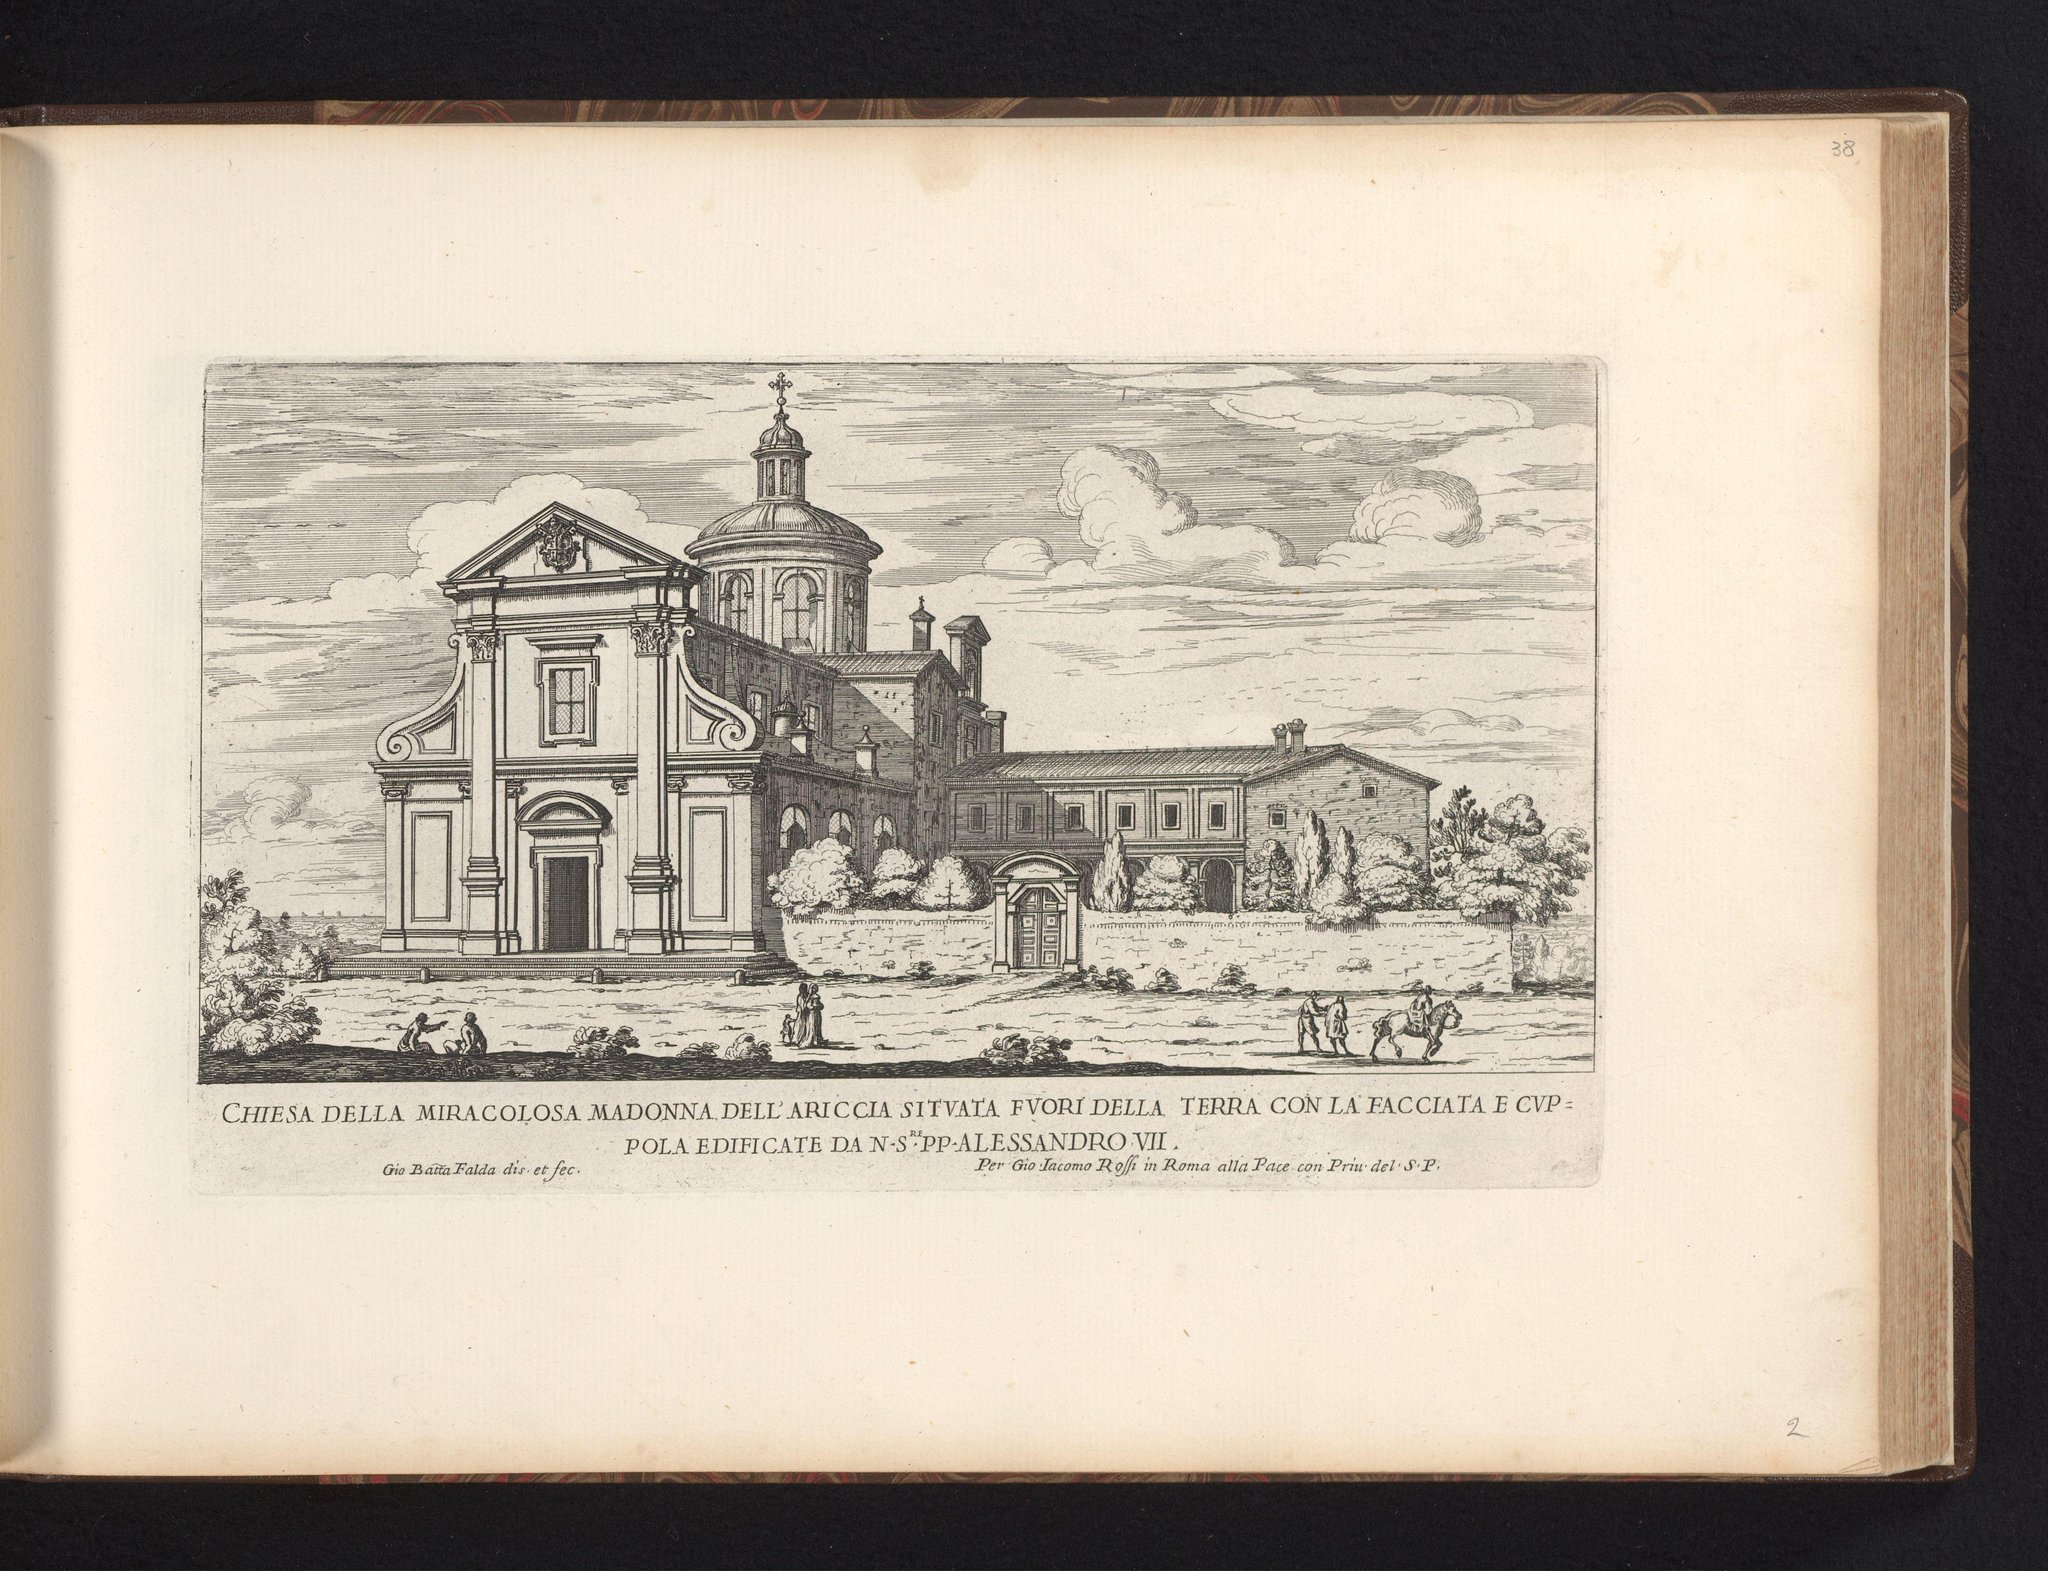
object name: album leaf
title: Moderne gebouwen te Rome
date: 1665-1667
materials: paper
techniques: etching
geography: italy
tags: city-view, and landscape with man-made constructions, church (exterior)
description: Deze prent maakt deel uit van een reeks van 17 prenten met voorstellingen van gebouwen in Rome. Samen met vier andere reeksen vormt het de grote reeks: 'Il nuovo teatro di Roma moderna'.